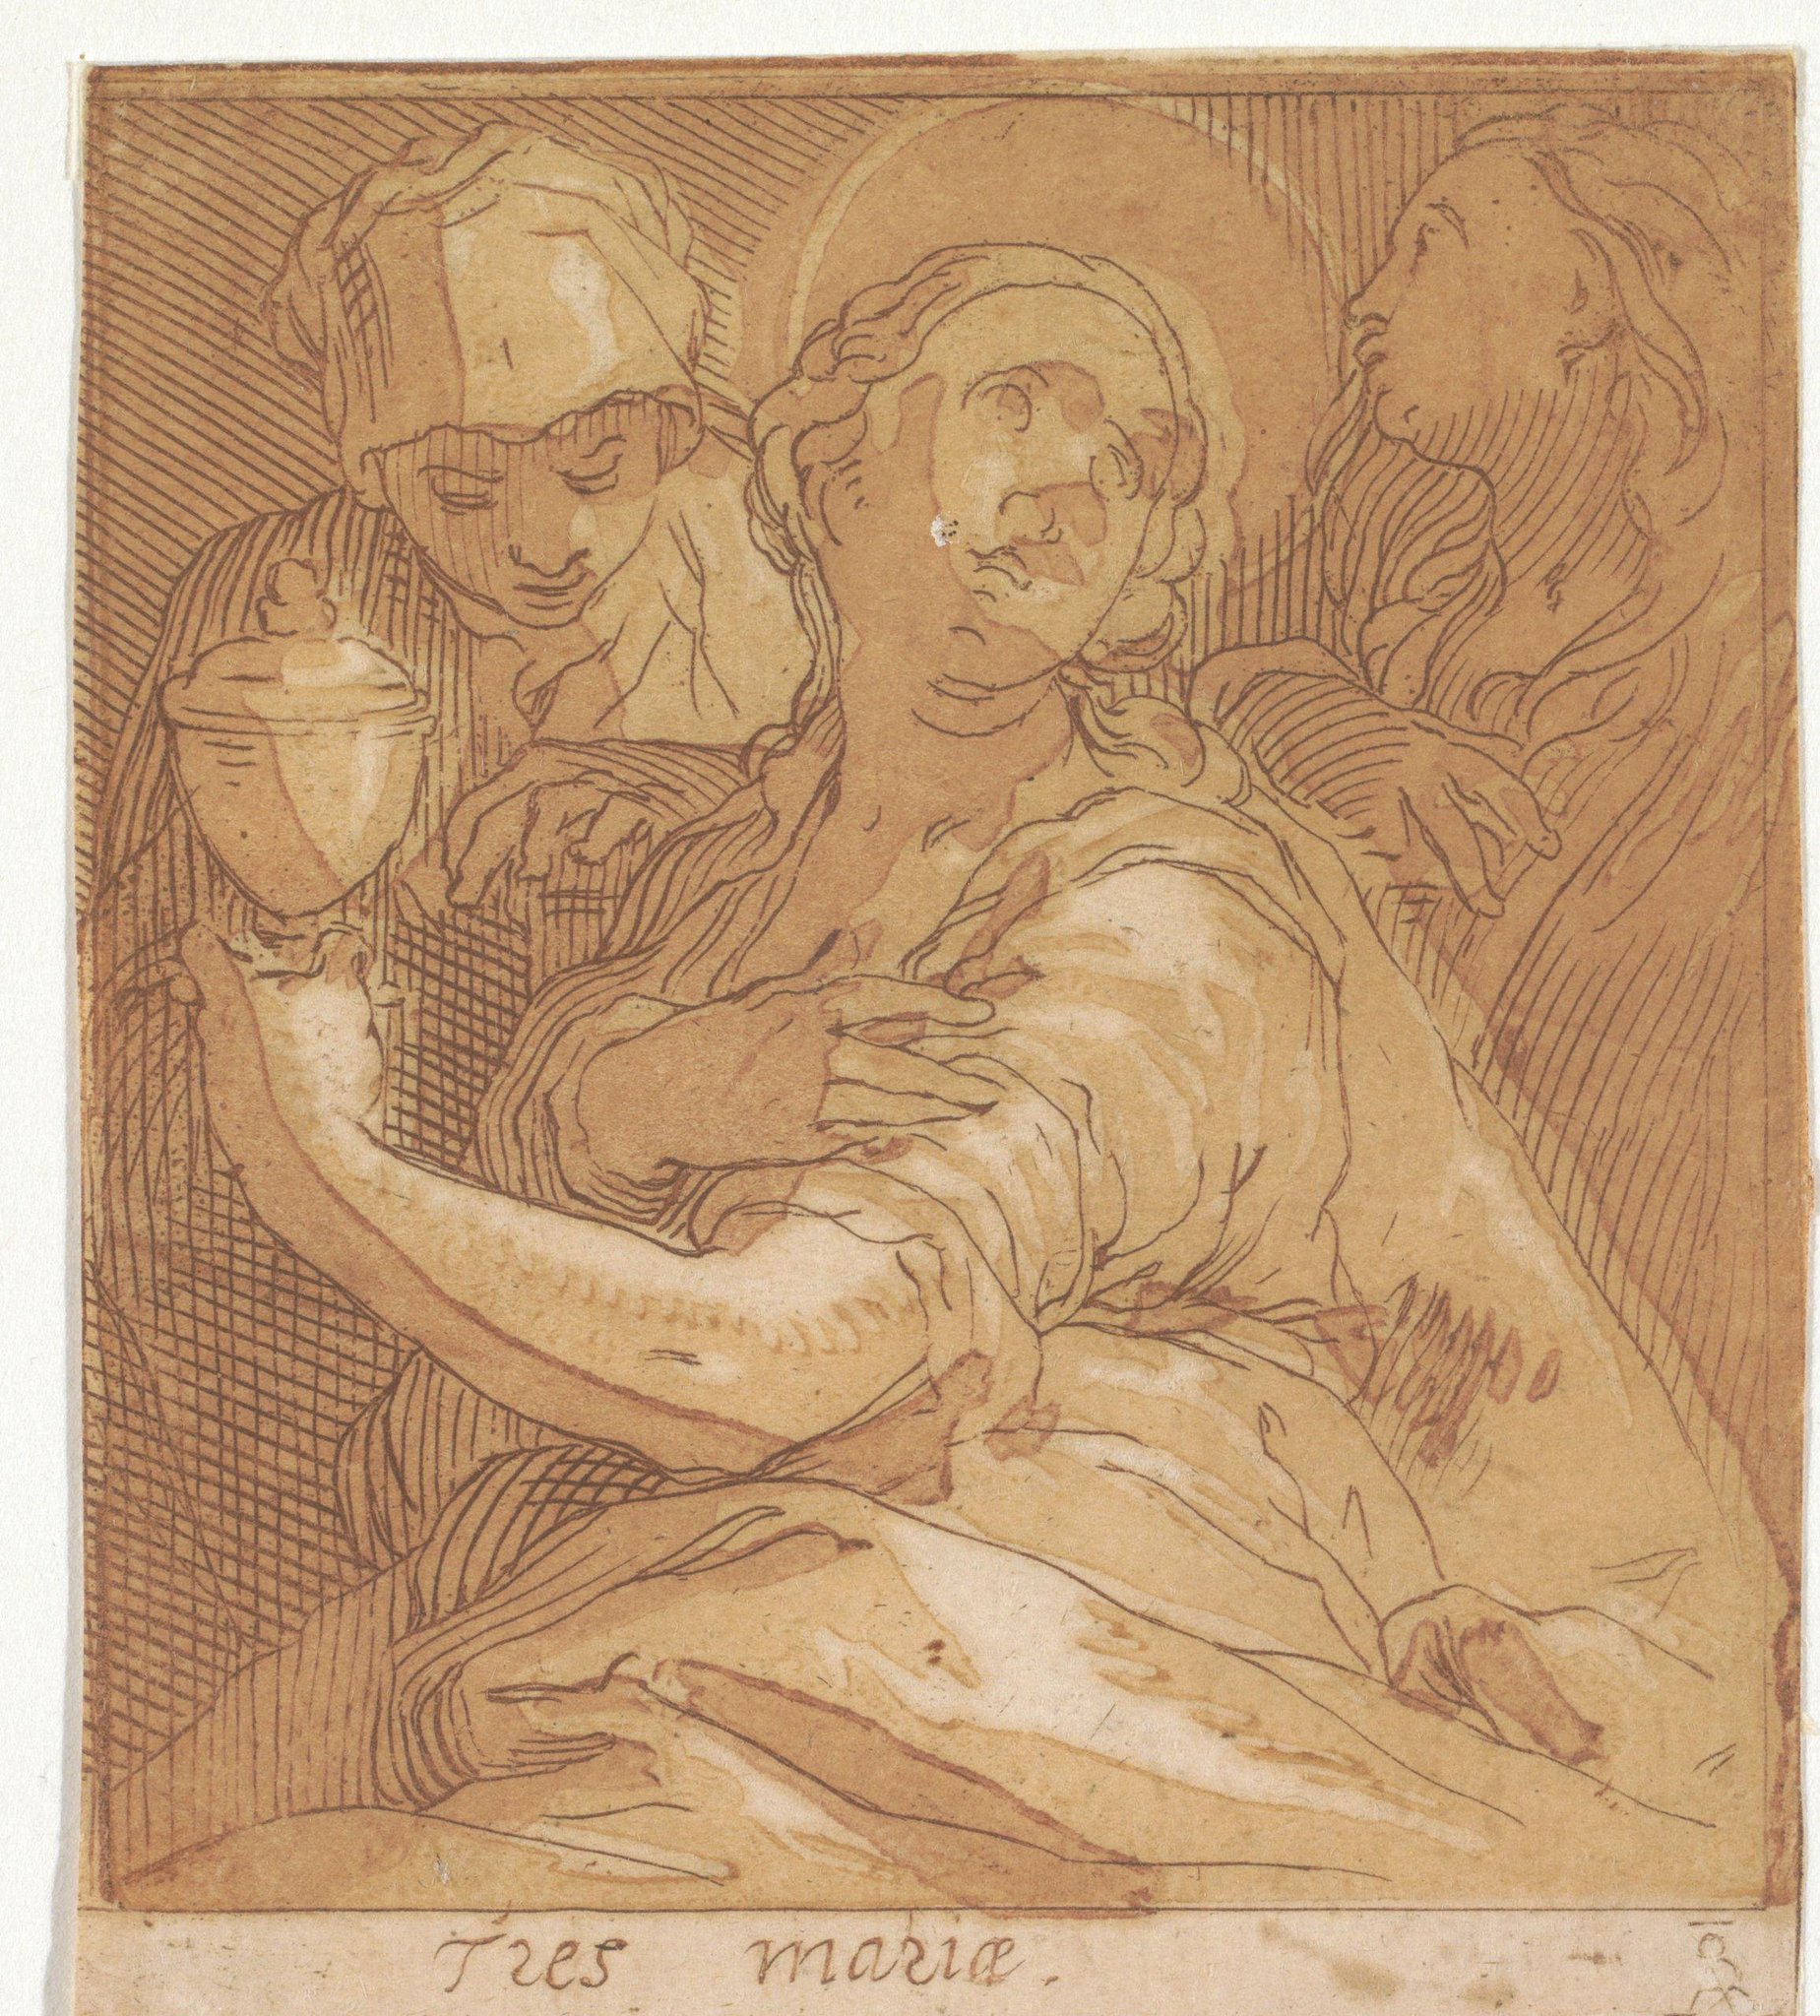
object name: print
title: Drie Maria’s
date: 1610-1615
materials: paper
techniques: woodcut, etching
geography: netherlands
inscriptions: collector's mark: Lugt 240